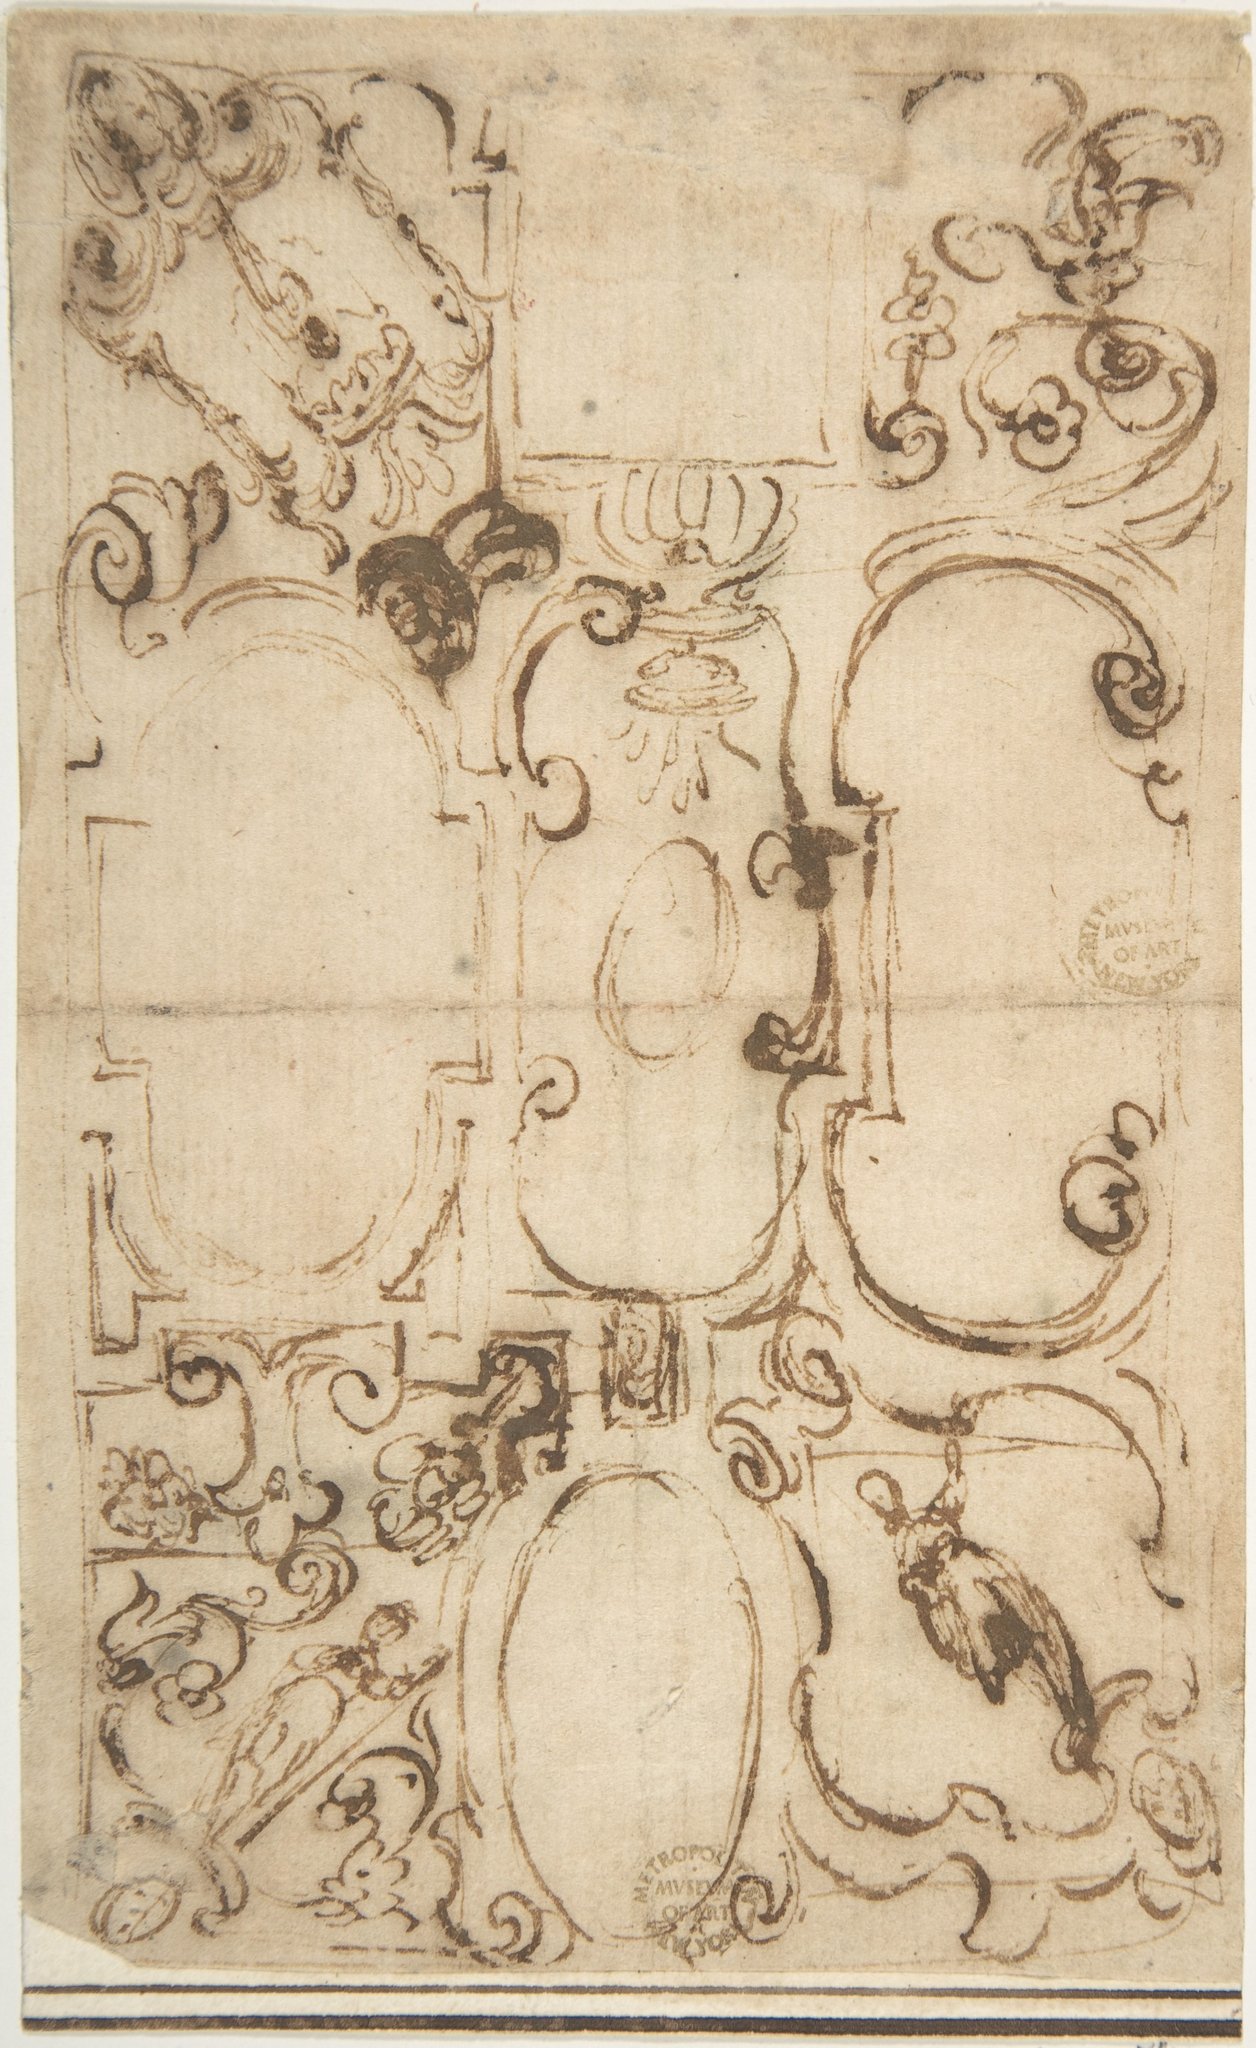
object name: drawing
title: Sketch for Ceiling Decoration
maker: anonymous, italian, 16th century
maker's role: artist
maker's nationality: italian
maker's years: 1550-1600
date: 1501-1600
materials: ink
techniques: pen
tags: ornament,ceilings